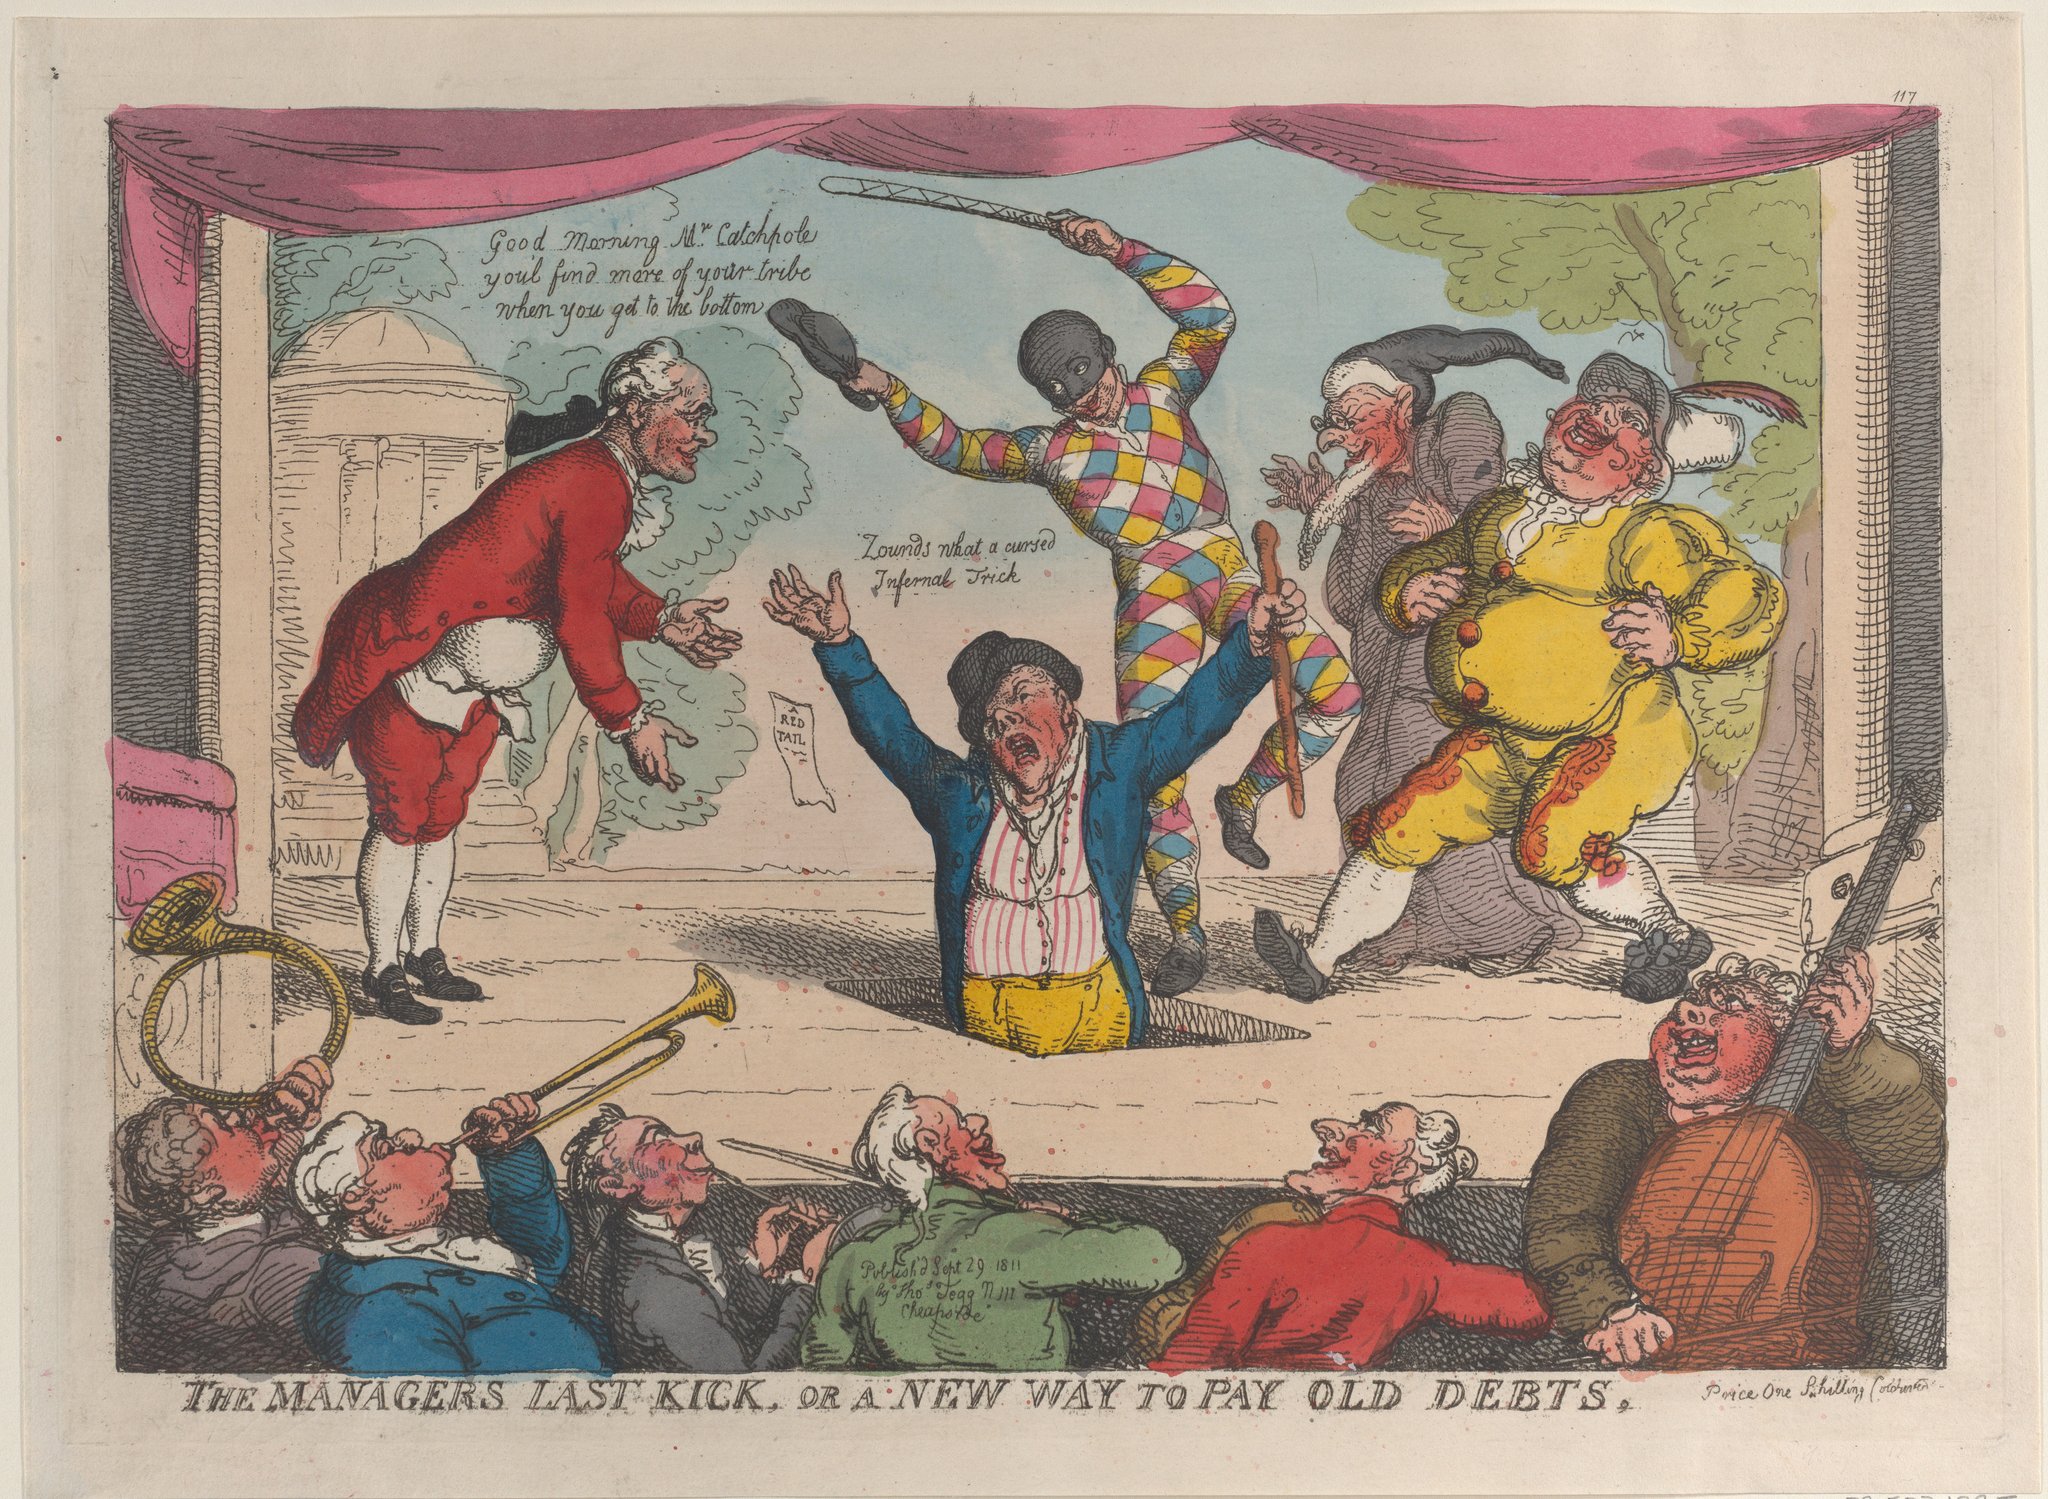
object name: print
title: The Manager's Last Kick, or a New Way to Pay Old Debts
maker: thomas rowlandson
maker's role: artist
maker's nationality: british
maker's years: 1757-1827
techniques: etching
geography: london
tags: satire,theatre,men,actors,musicians